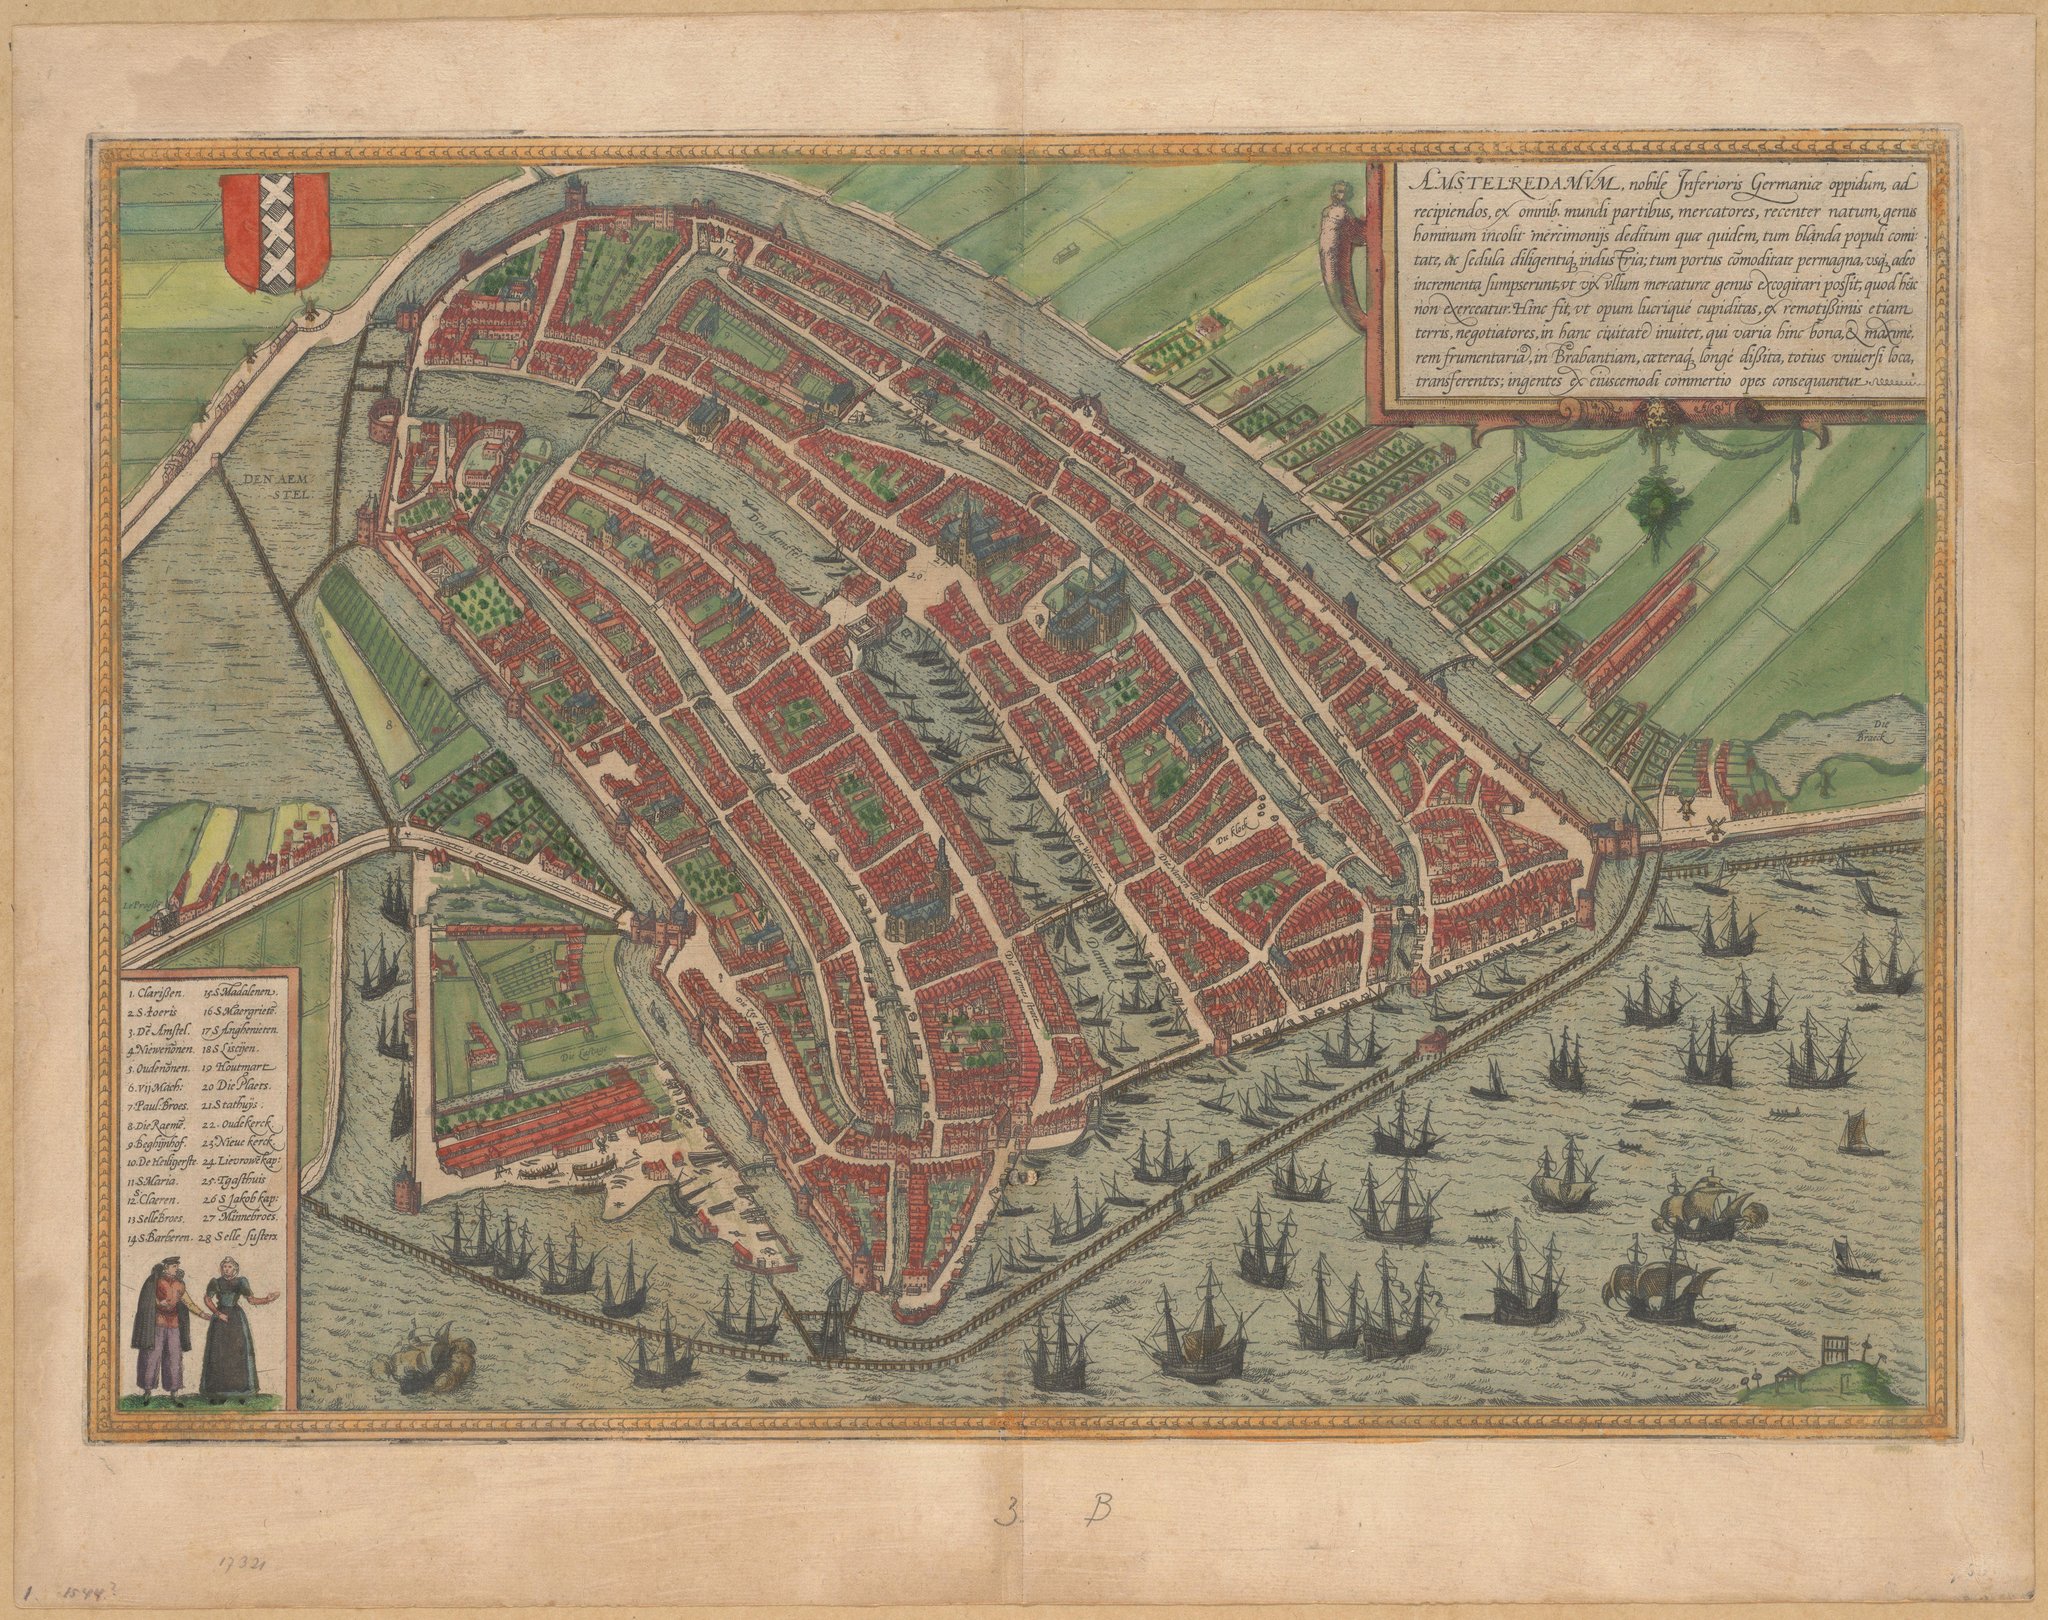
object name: print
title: Plattegrond van Amsterdam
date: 1572-1618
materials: ink, paper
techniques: engraving, etching, hand coloring, letterpress printing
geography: cologne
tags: coat of arms (as symbol of the state, etc.) (+ city; municipal), folk costume, regional costume, maps of cities, amsterdam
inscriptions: collector's mark: Lugt 1641b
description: Prent mogelijk uit: Braun, Georg en Frans Hogenberg. Civitates orbis terrarum. Keulen: Theodorus Graminaeus, 1572. Of uit latere edities in het Latijn, tot 1618.